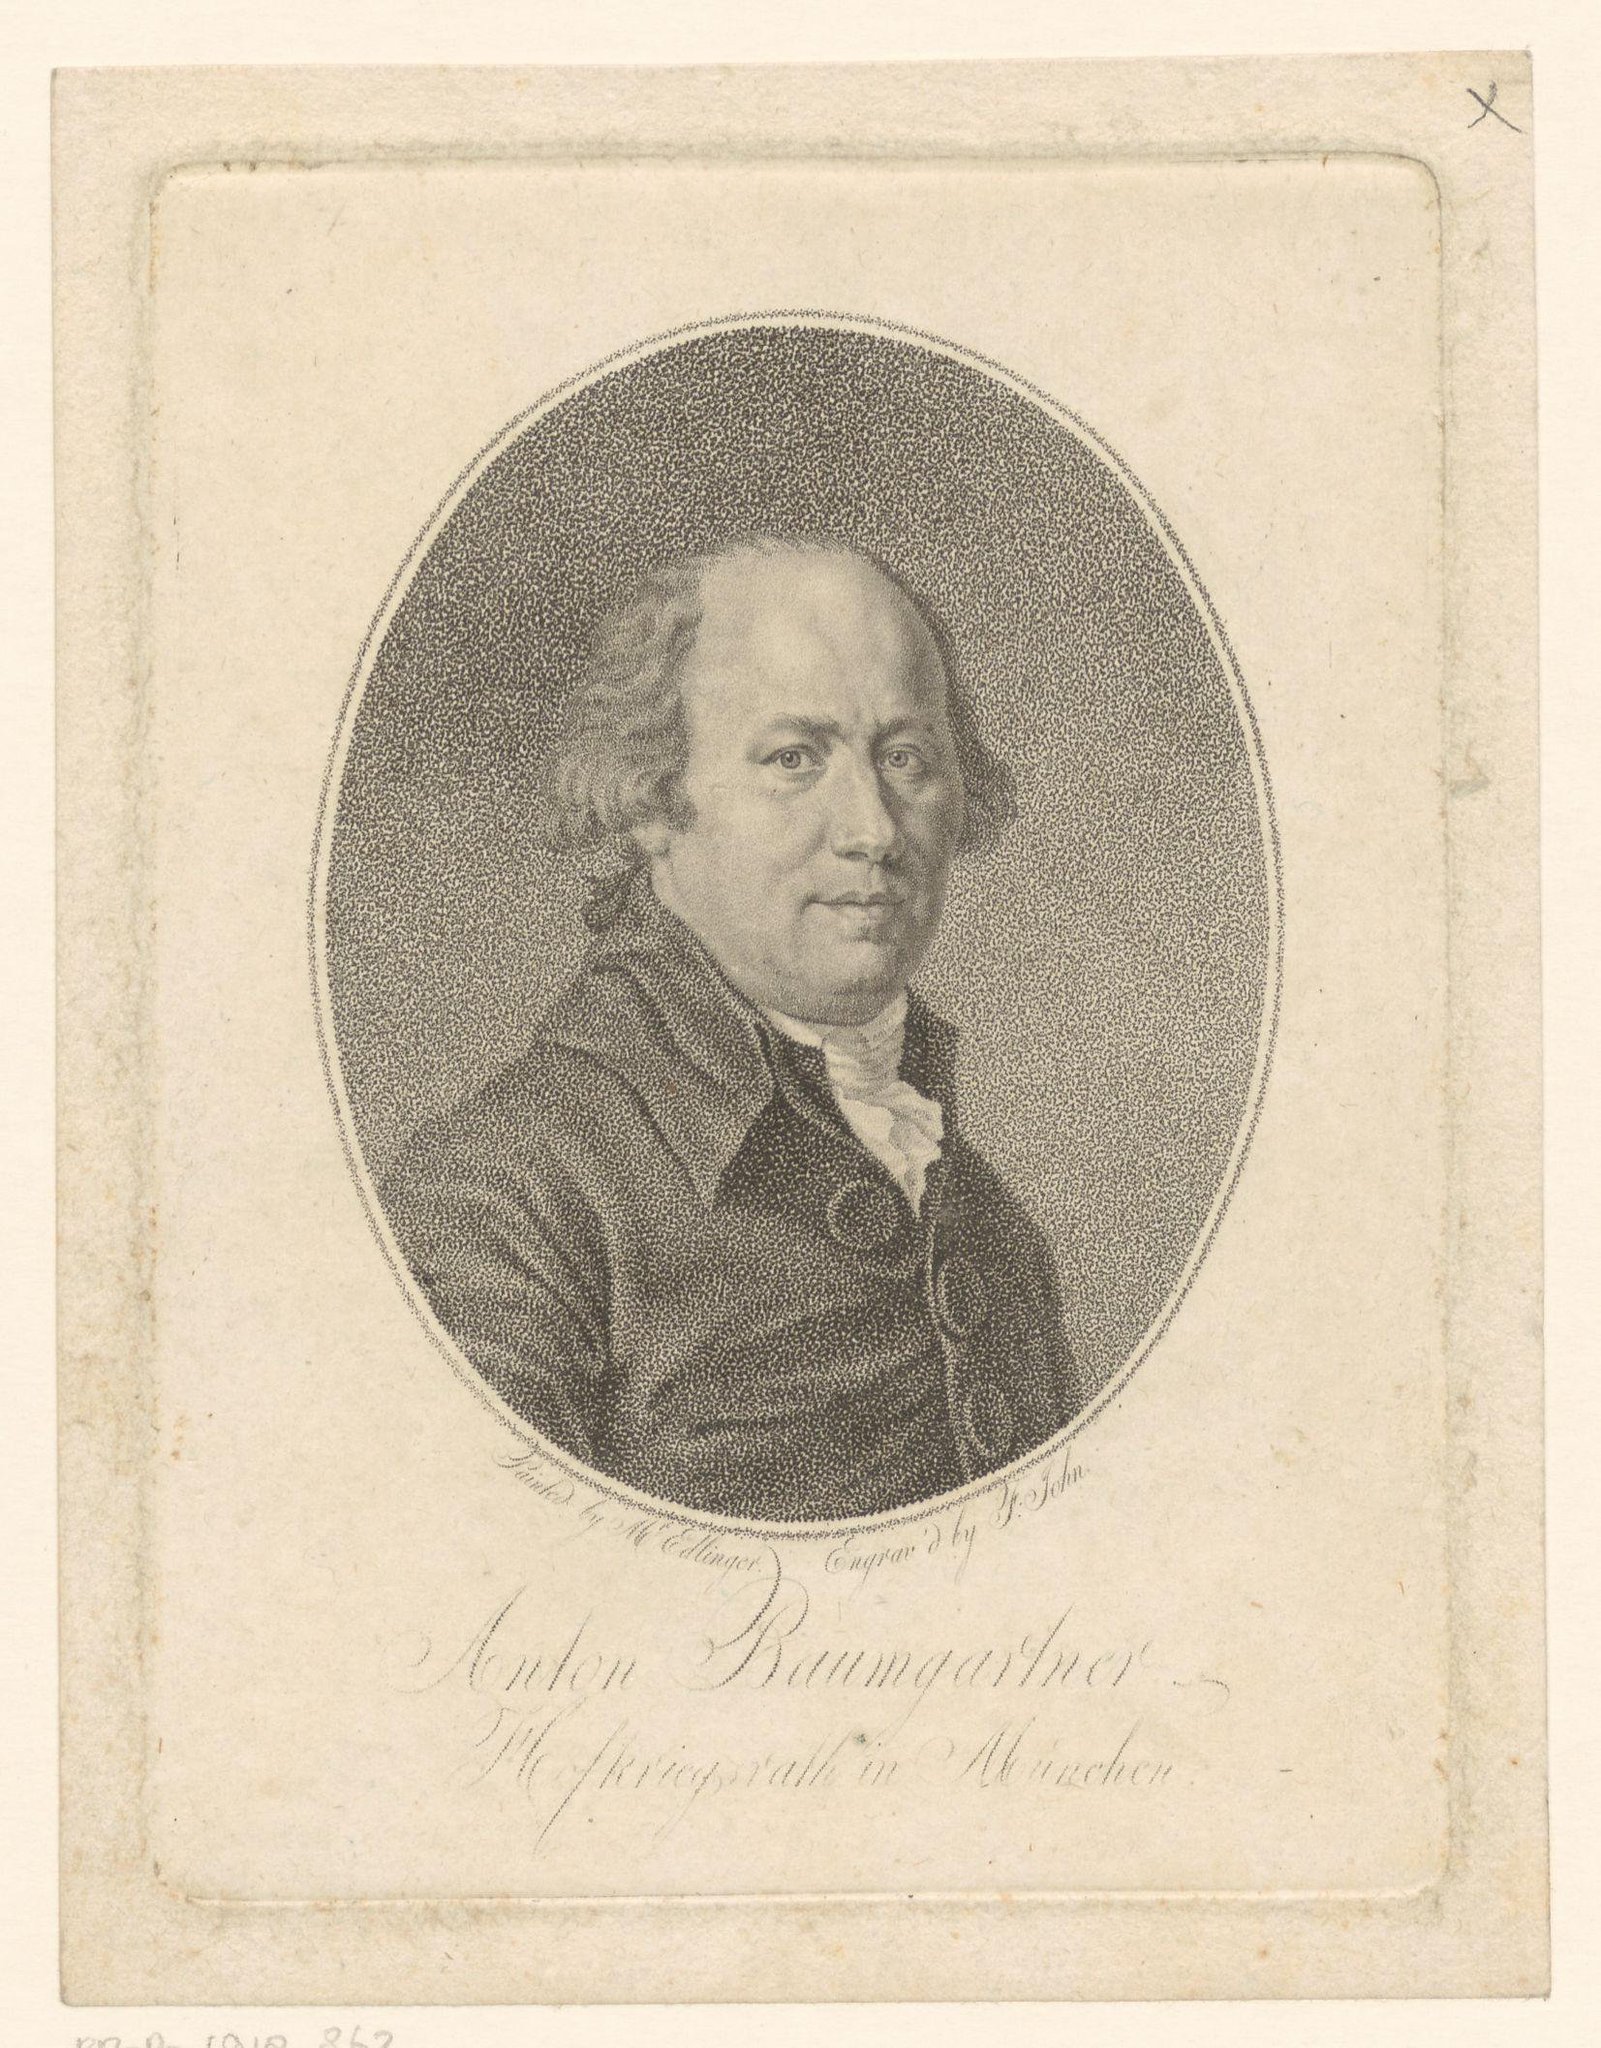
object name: print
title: Portret van Anton Baumgartner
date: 1779-1843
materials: paper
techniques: stippling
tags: historical persons, lawyer, attorney at law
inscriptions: number: ‘16.’, collector's mark: Lugt 2233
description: Deze prent is gemaakt naar een schilderij dat zich in de collectie van het Münchner Stadtmuseum bevindt onder inv.nr. GM IIc/60.